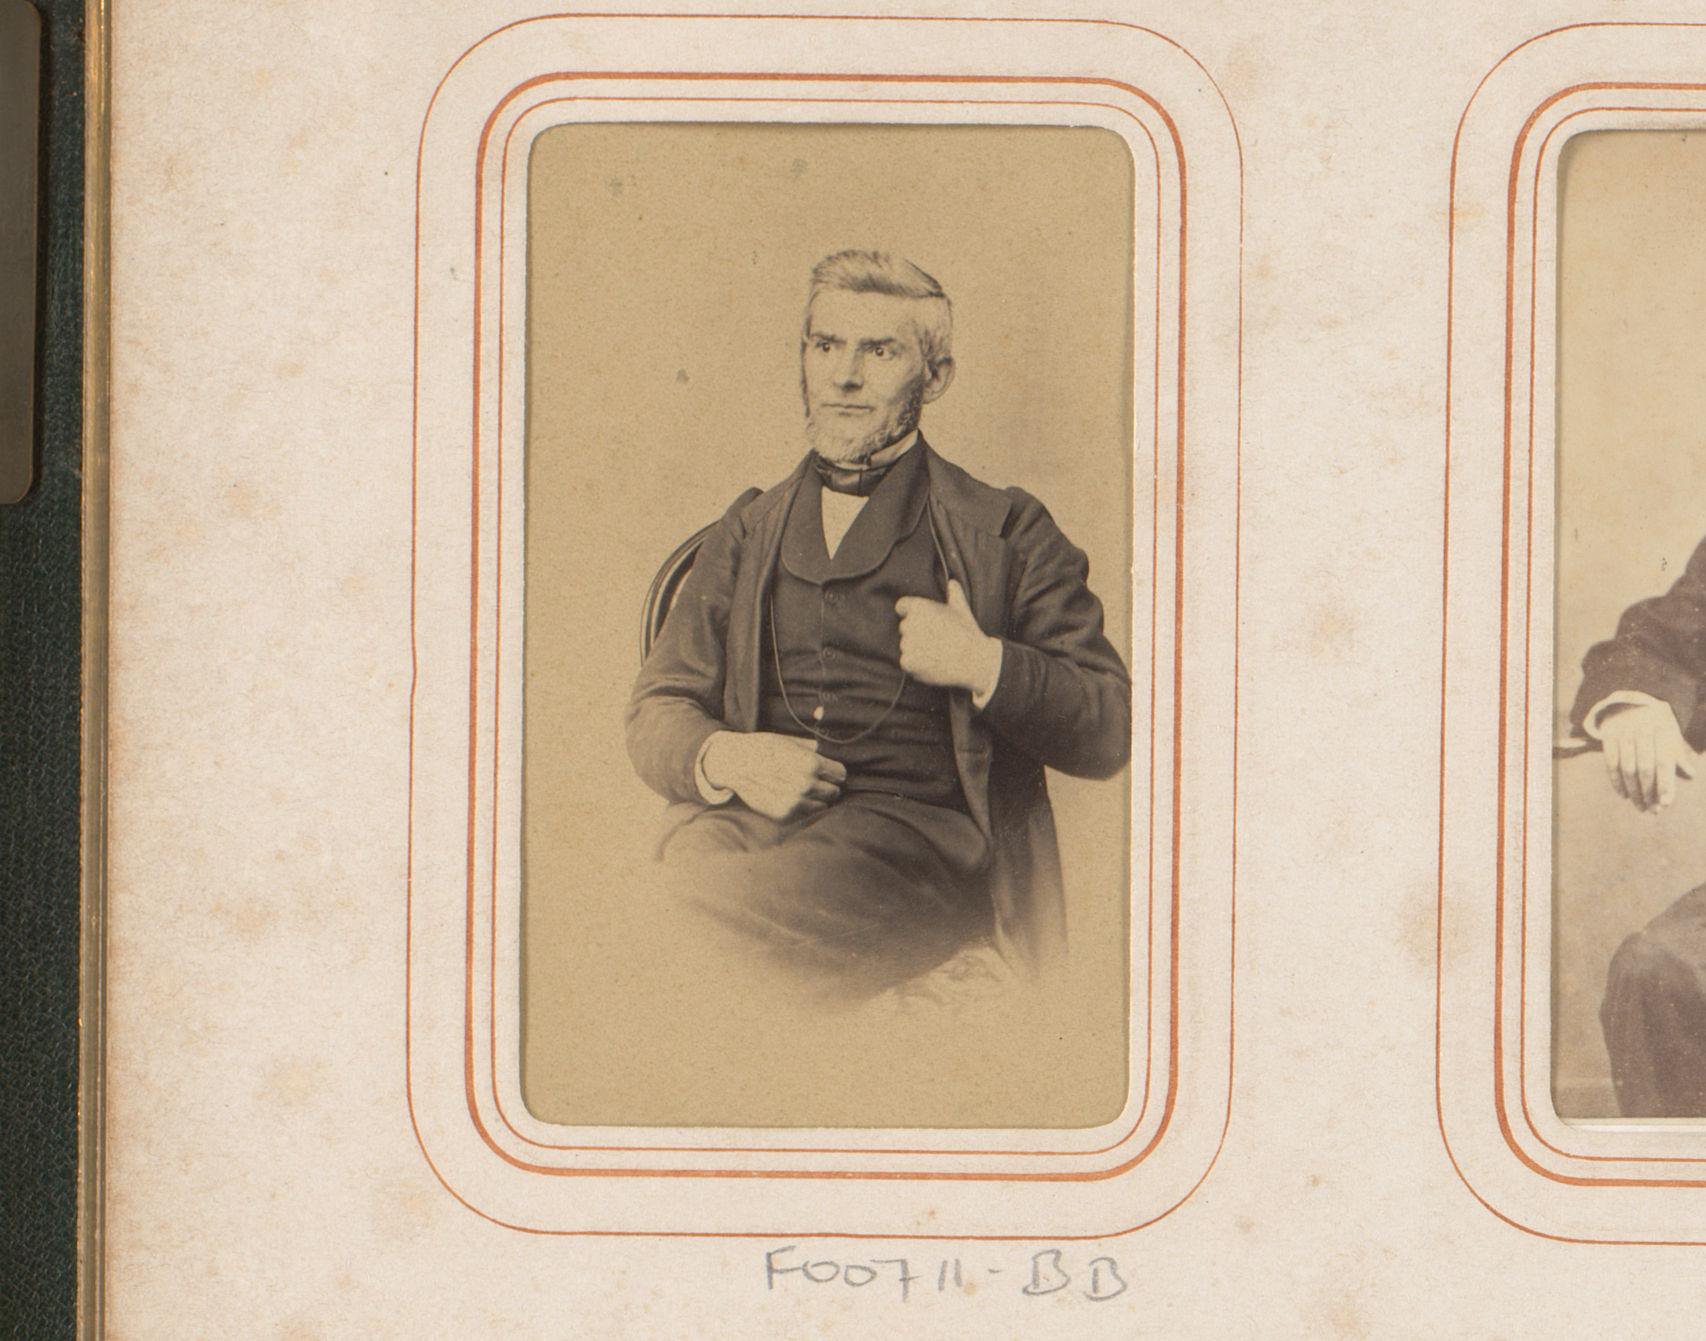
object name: album leaf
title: Portret van een zittende man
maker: johannes peter metzger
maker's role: fotograaf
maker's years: 1830-1867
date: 1855-1880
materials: cardboard, photographic support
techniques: albumen print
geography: utrecht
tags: historical persons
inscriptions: inscription: ‘J.P. Metzger/ Photographe/ Utrecht’